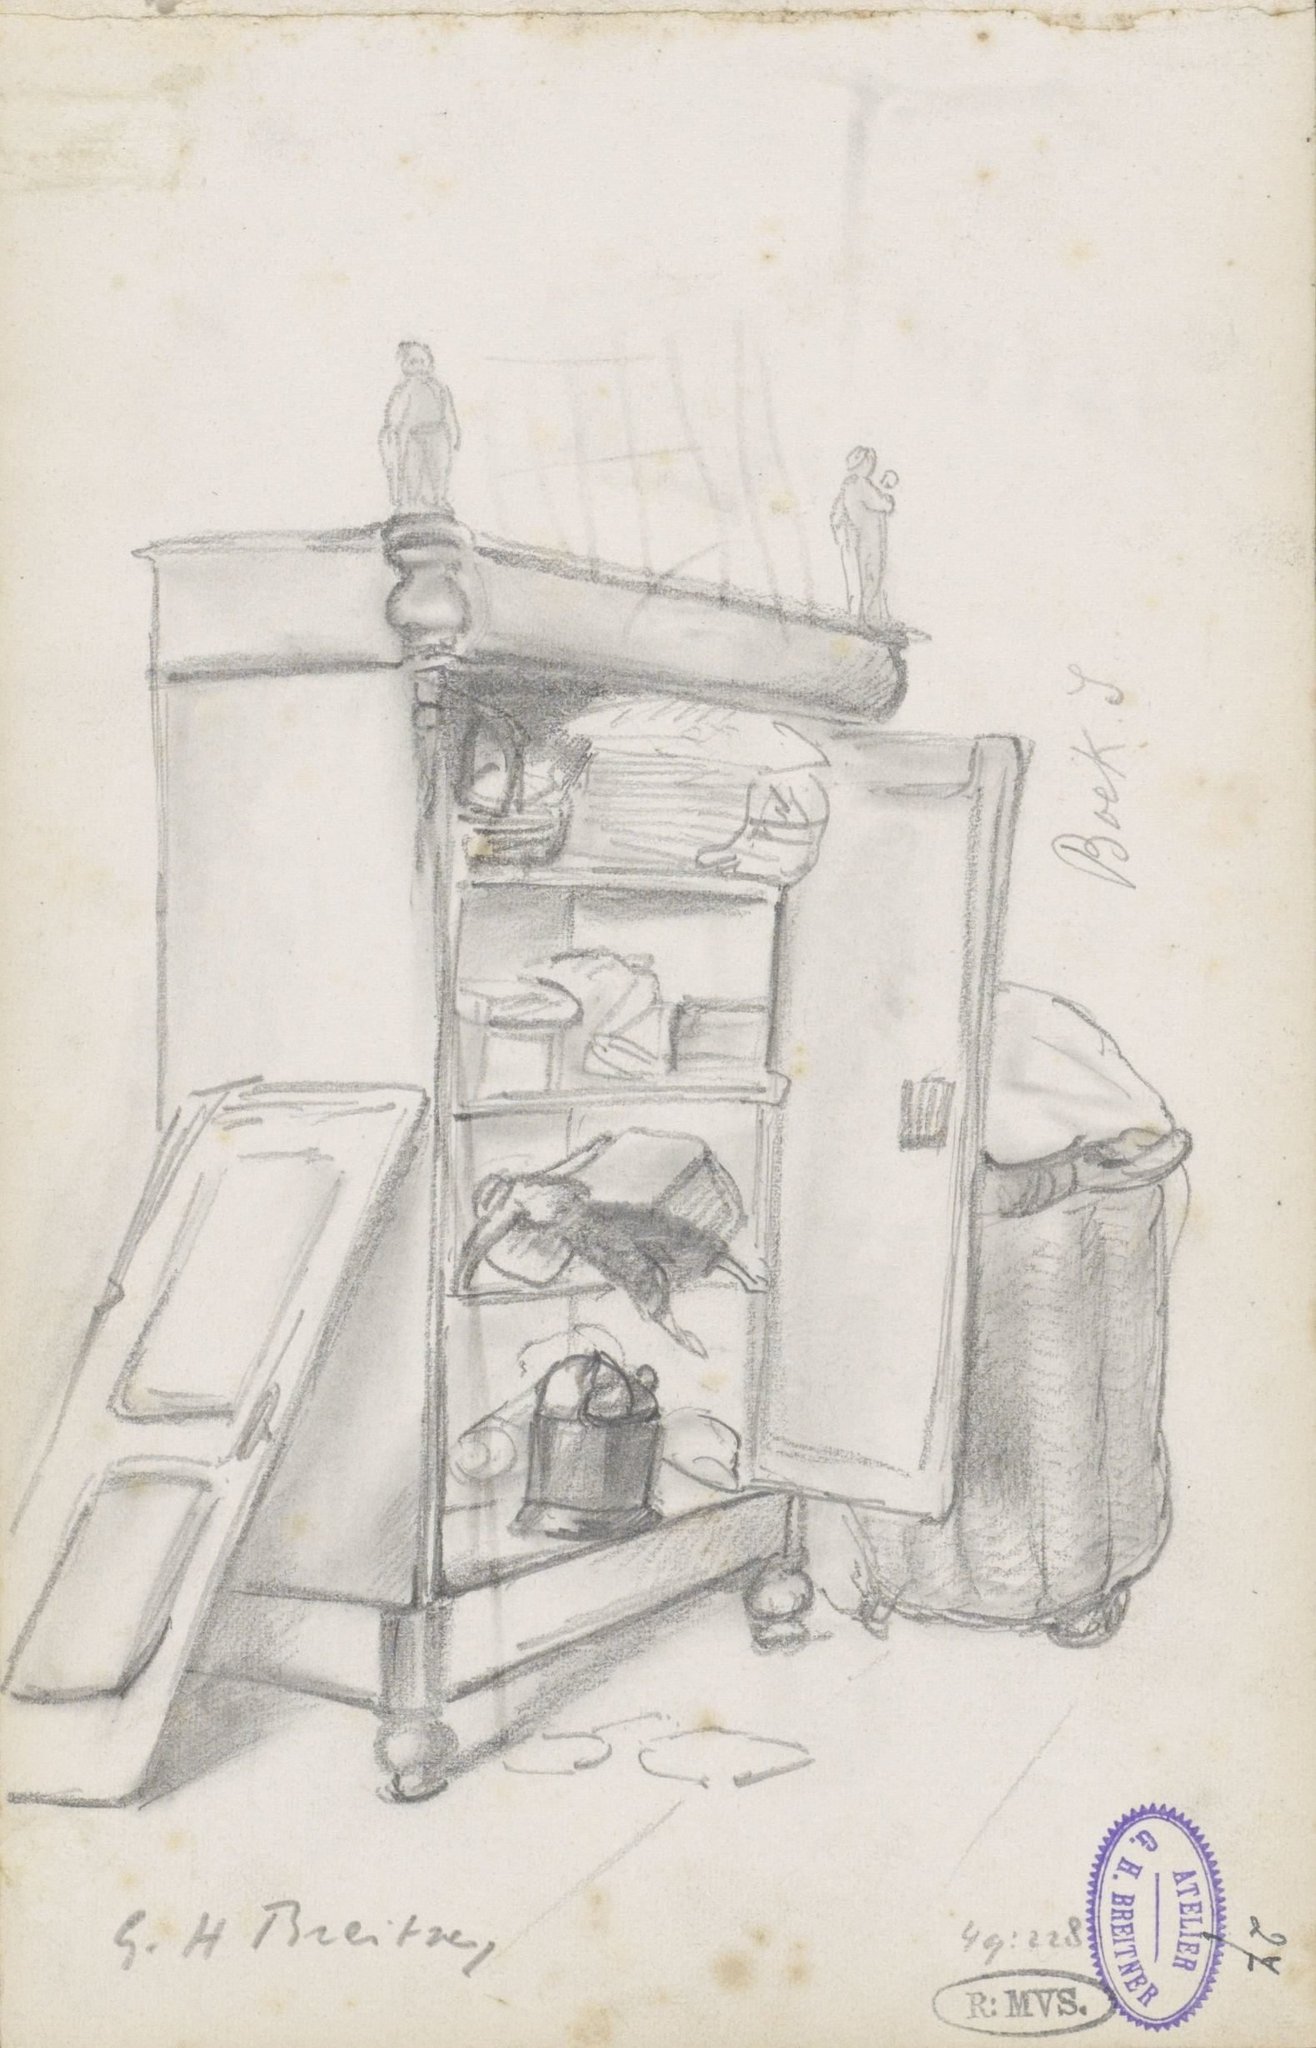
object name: drawing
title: Openstaande kast met spullen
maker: george hendrik breitner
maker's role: draughtsman, painter, print maker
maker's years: 1857-1923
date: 1874-1876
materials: paper, pencil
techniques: stumping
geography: rotterdam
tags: cupboard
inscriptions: collector's mark: Lugt 2228, signature: ‘G.H Breitner’, workshop stamp: Lugt 291d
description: Deze tekening heeft oorspronkelijk als blad 27 deel uitgemaakt van een schetsboek. Zie voor dit schetsboek het gerelateerd object.